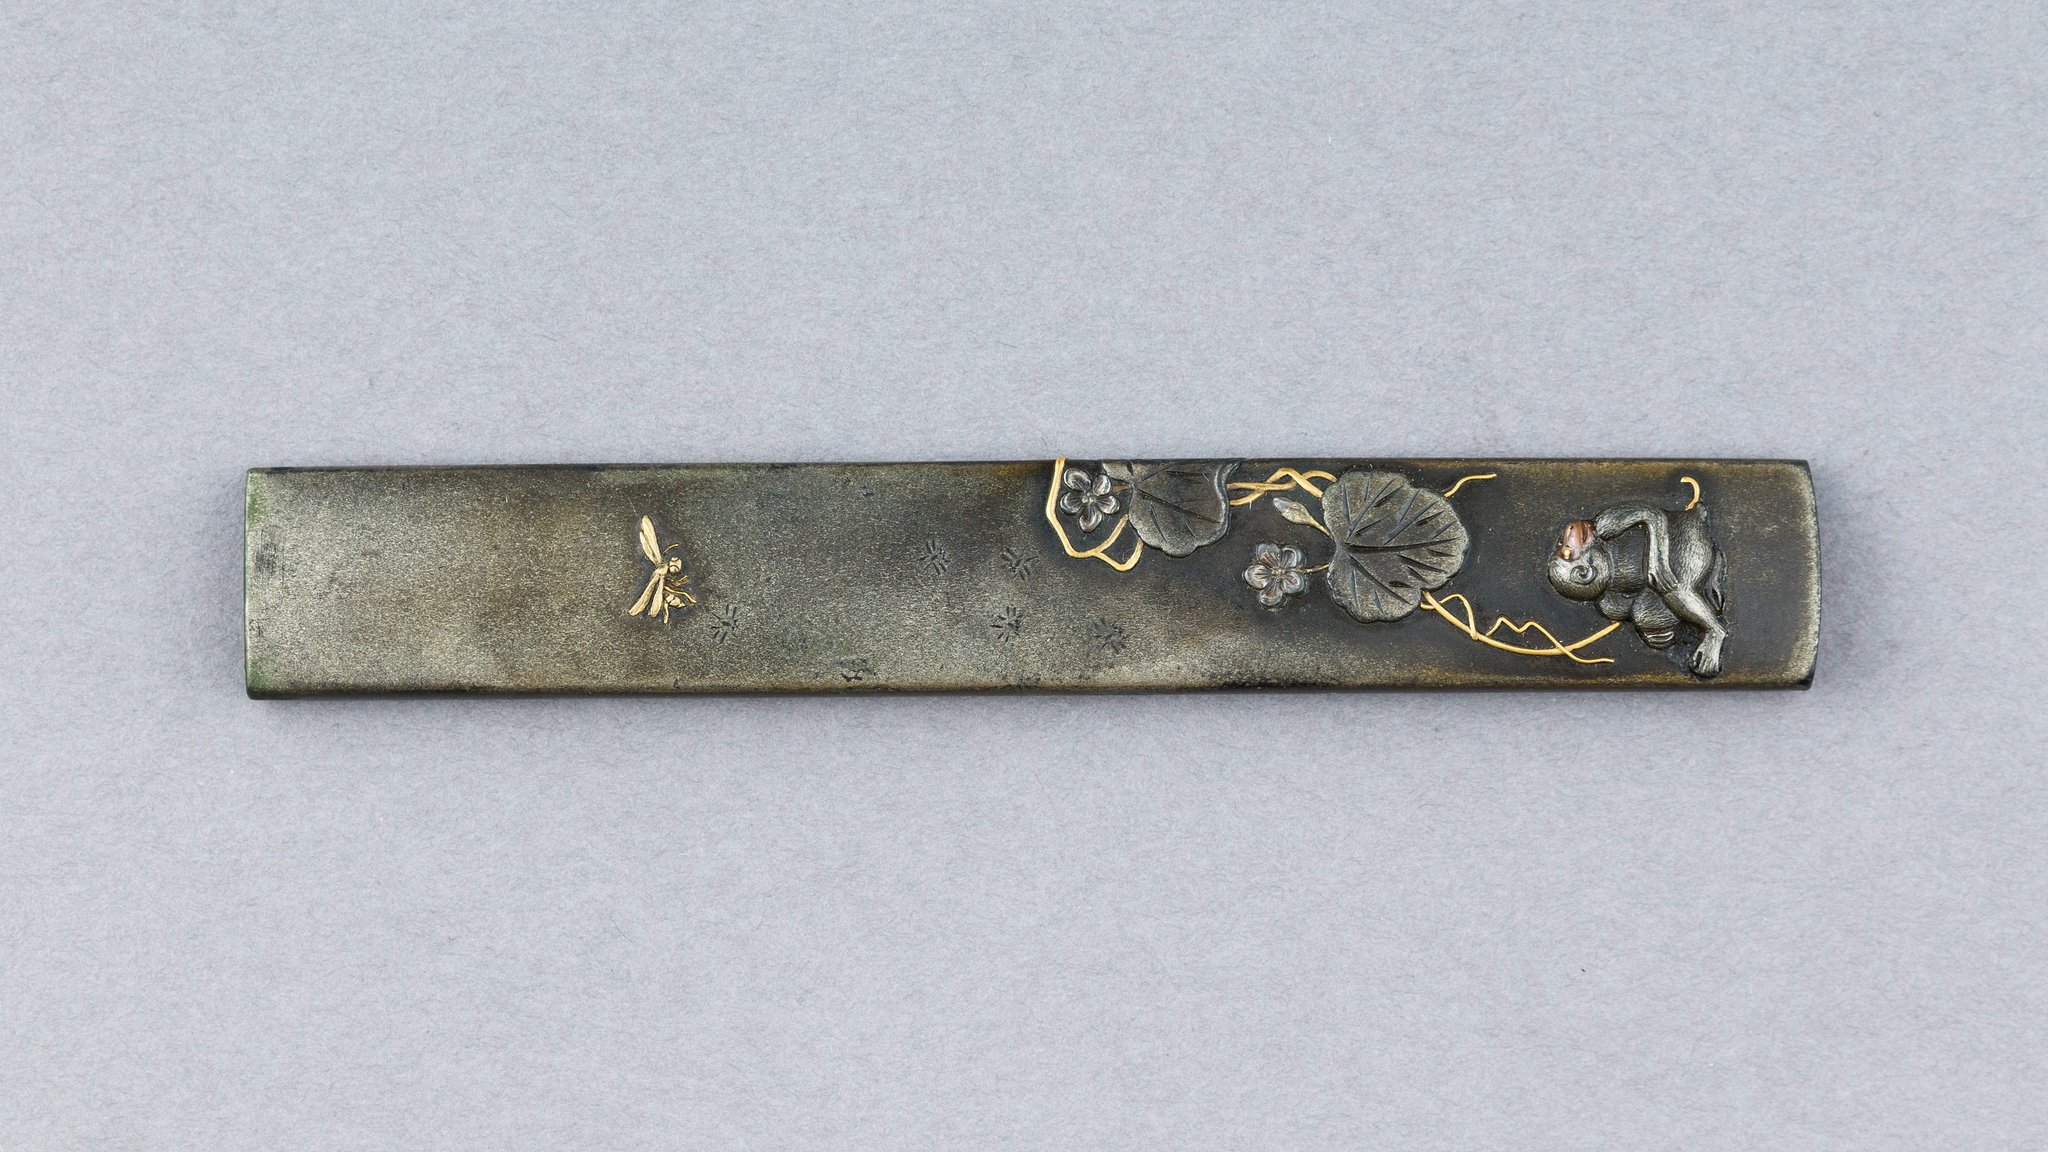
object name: knife handle kozuka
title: Knife Handle (Kozuka)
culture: japanese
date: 1615-1868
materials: copper, silver alloy, gold, silver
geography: japan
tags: monkeys,leaves